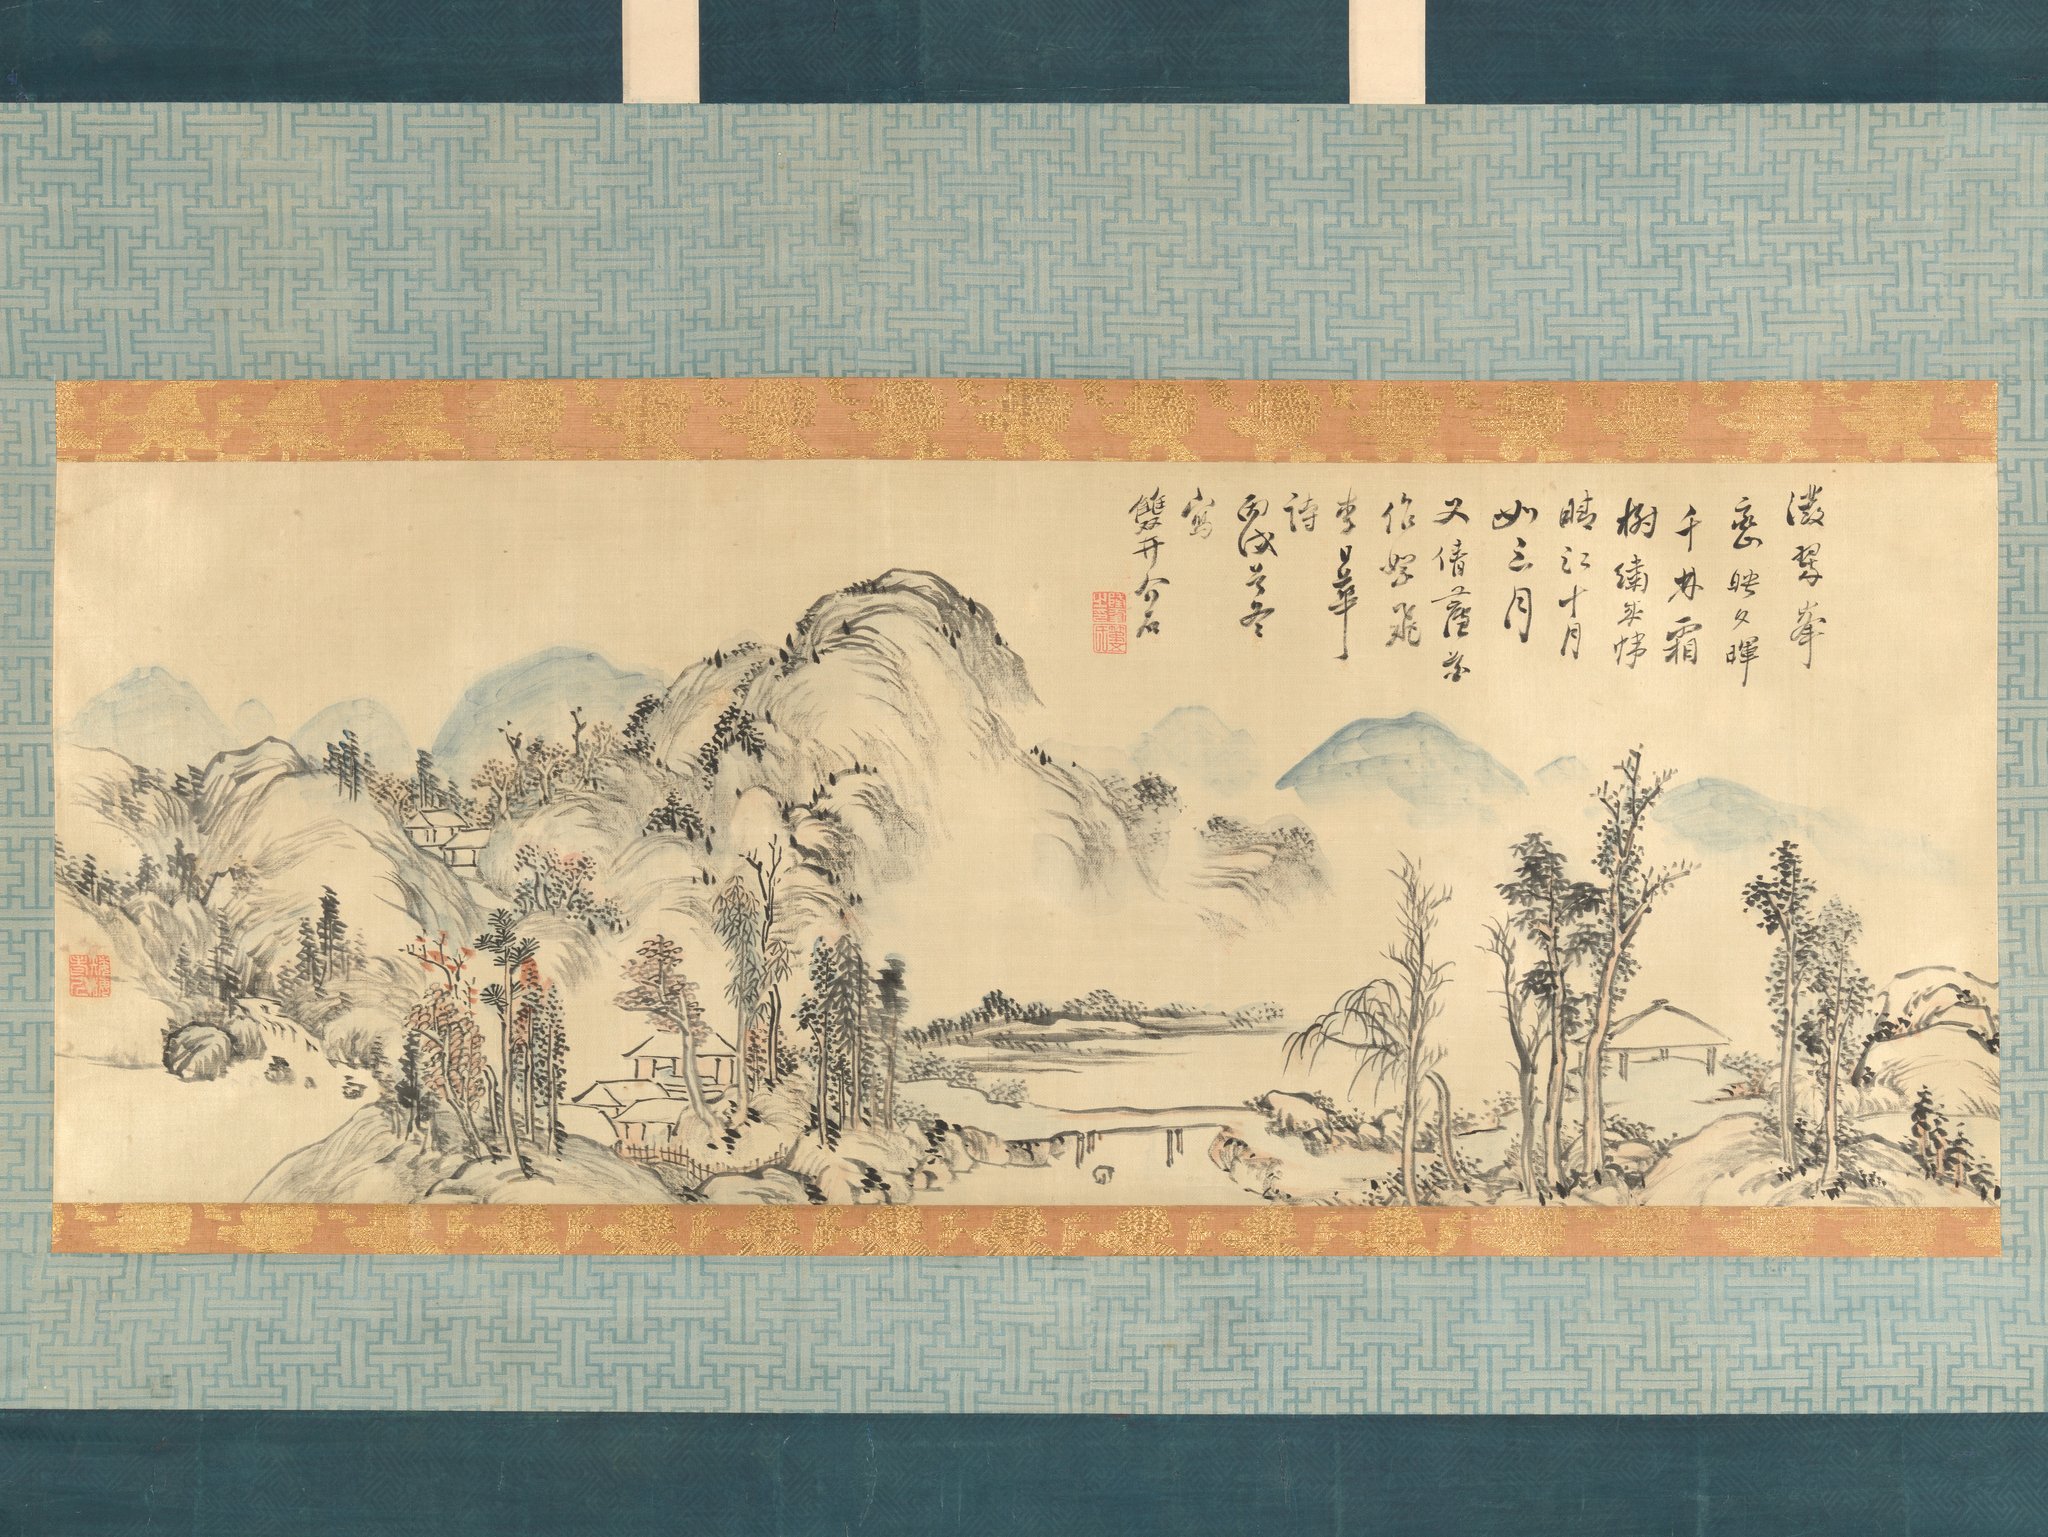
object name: hanging scroll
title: Green Peaks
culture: japanese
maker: noro kaiseki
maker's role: artist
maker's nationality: japanese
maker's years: 1747-1828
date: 1826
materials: ink, silk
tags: mountains,landscapes